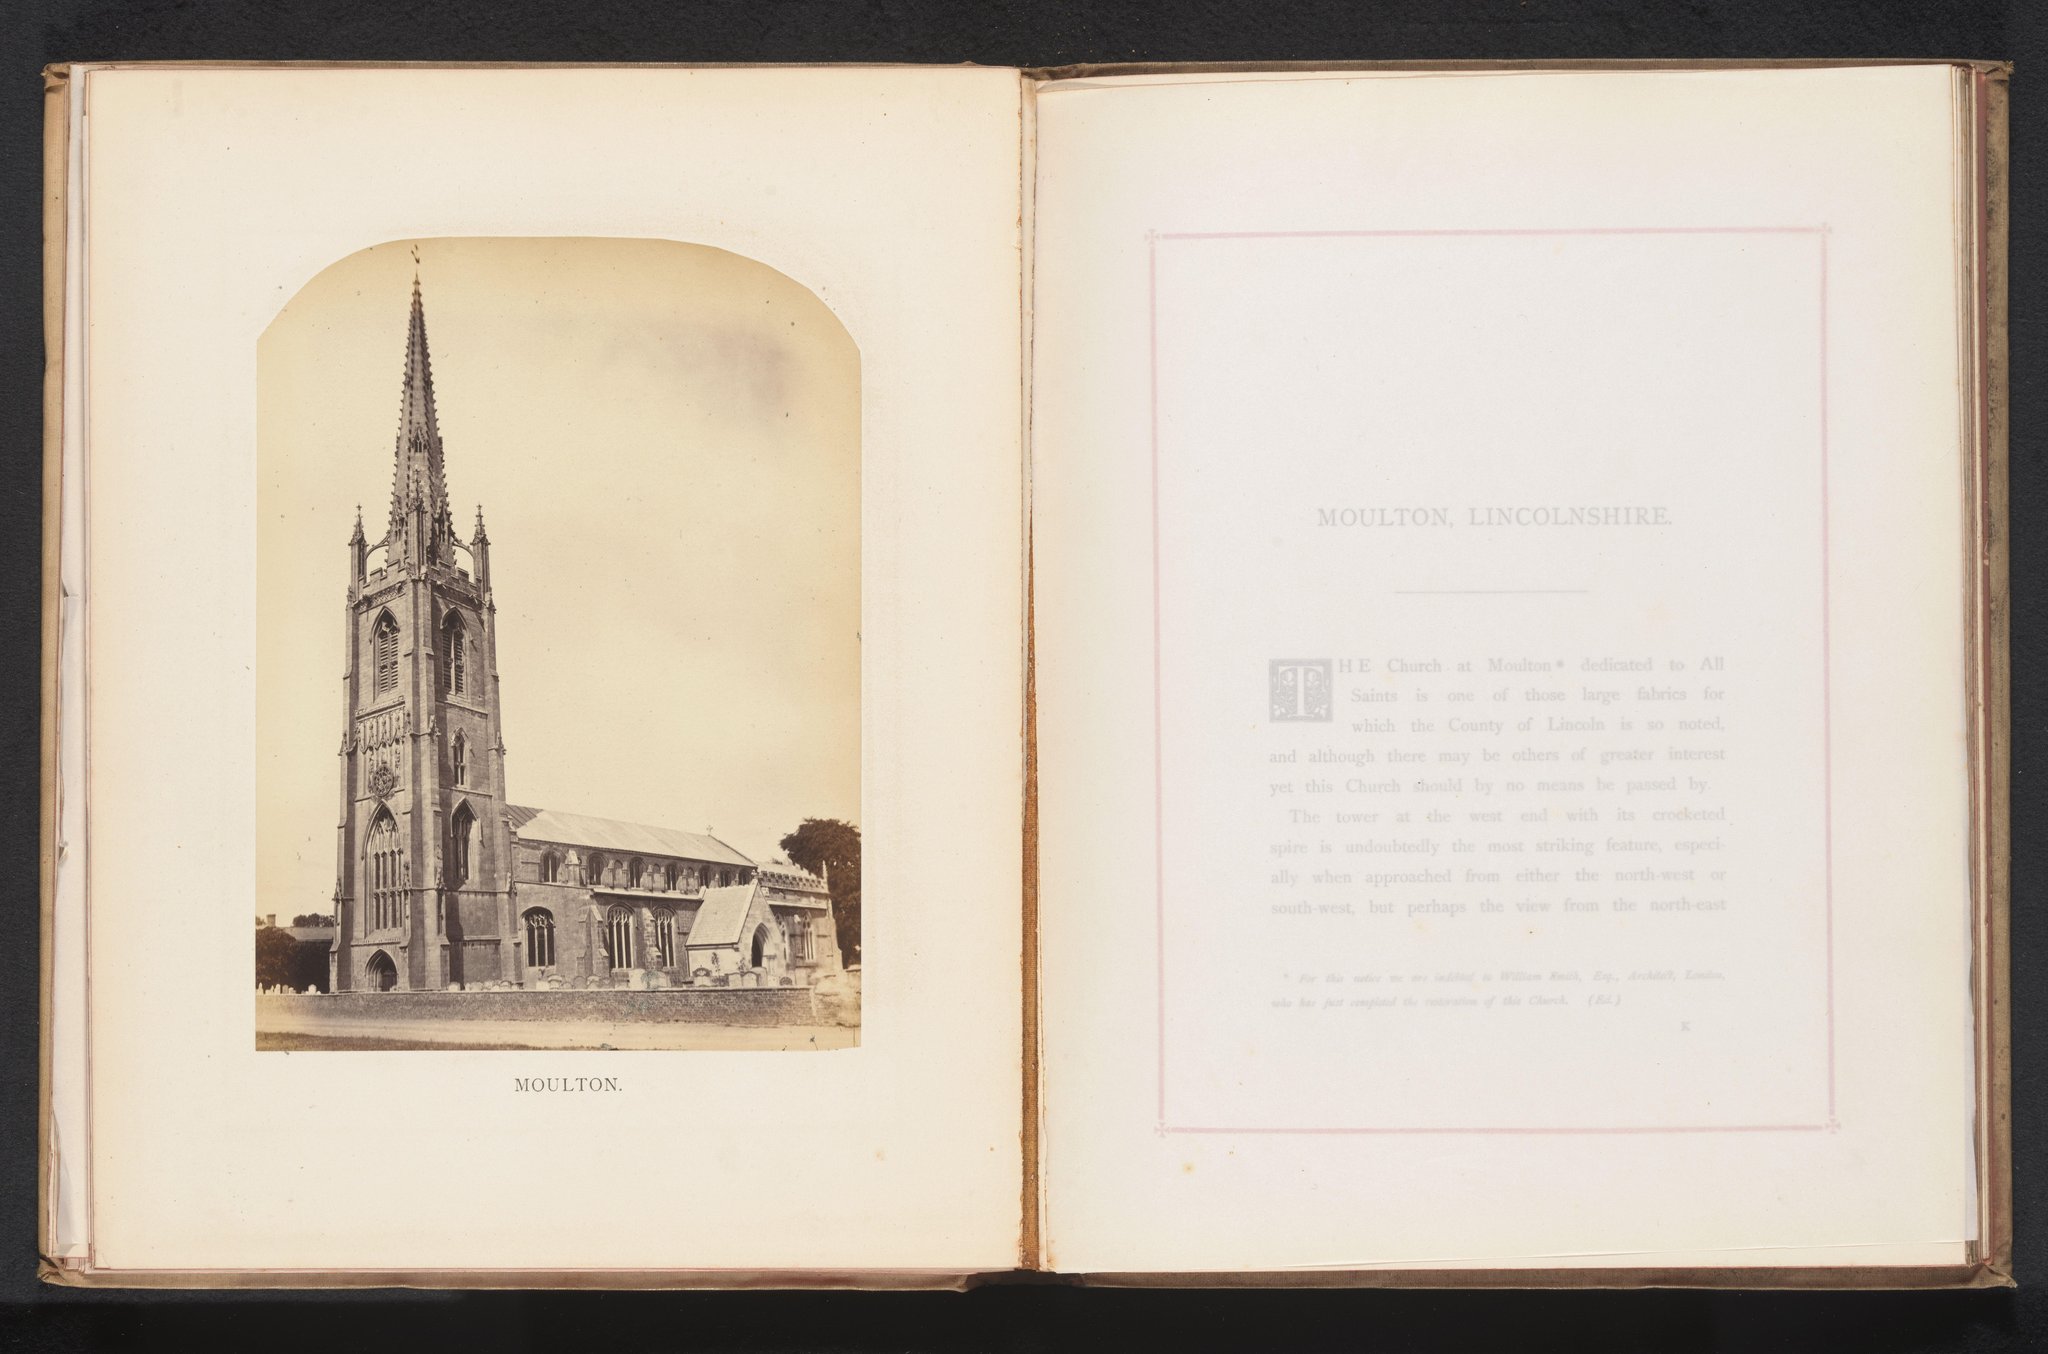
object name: page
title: Moulton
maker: Anonymous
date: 1858-1869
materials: photographic support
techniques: albumen print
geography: moulton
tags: church (exterior), façade (of house or building)